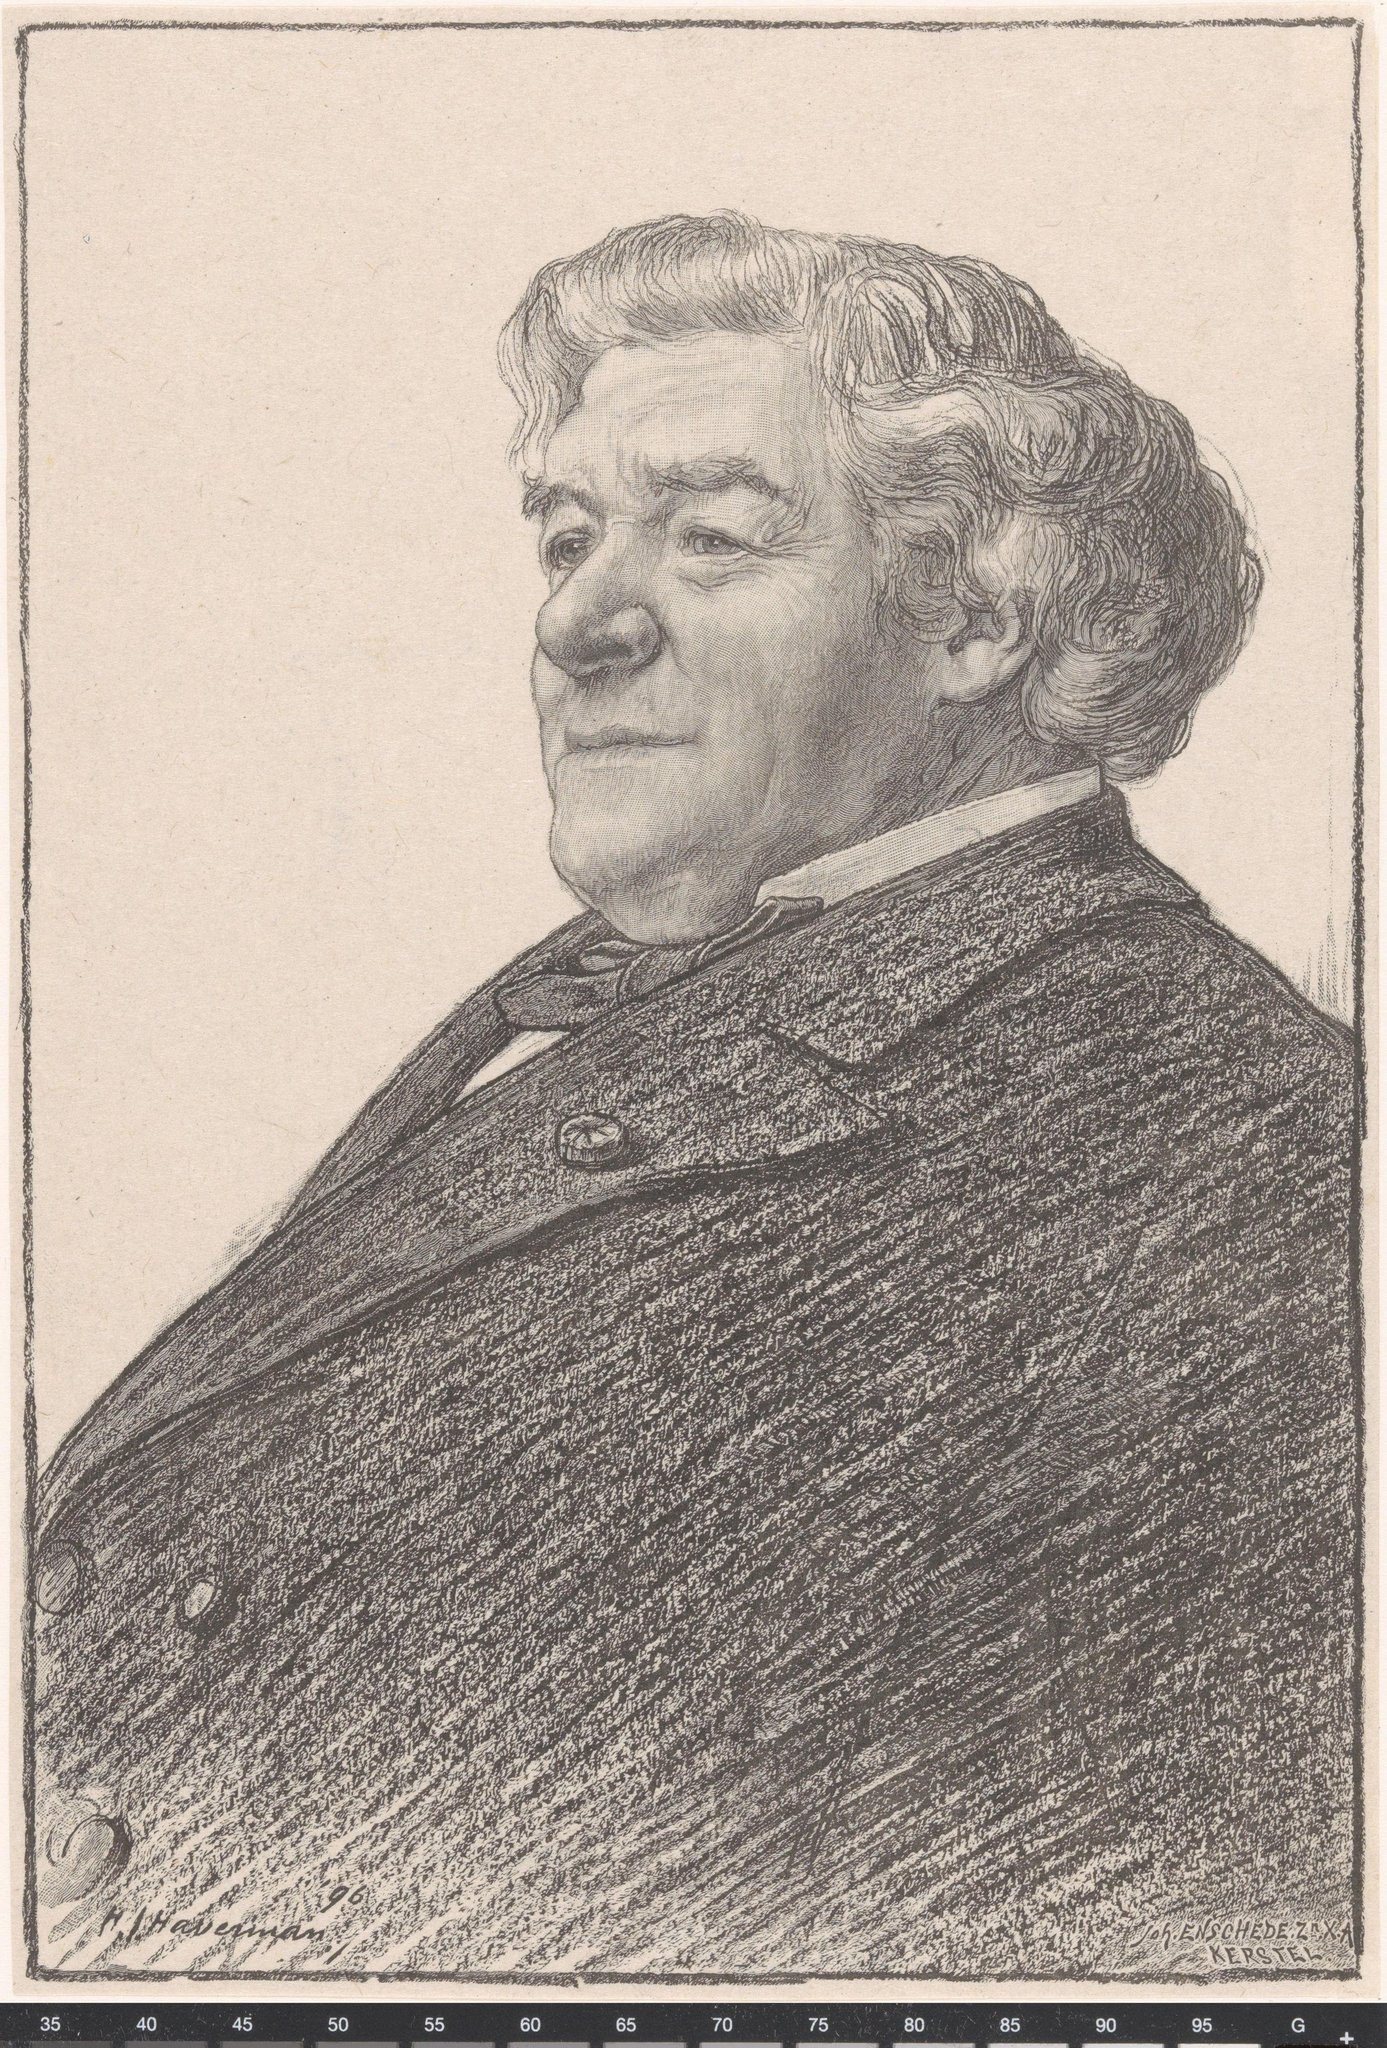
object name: print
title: Portret van Jacob Heinrich Krelage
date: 1896-1936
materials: paper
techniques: lithograph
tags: haarlem, historical persons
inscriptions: collector's mark: Lugt 2228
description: Een portret van tuinbouwkundige Jacob Heinrich Krelage.